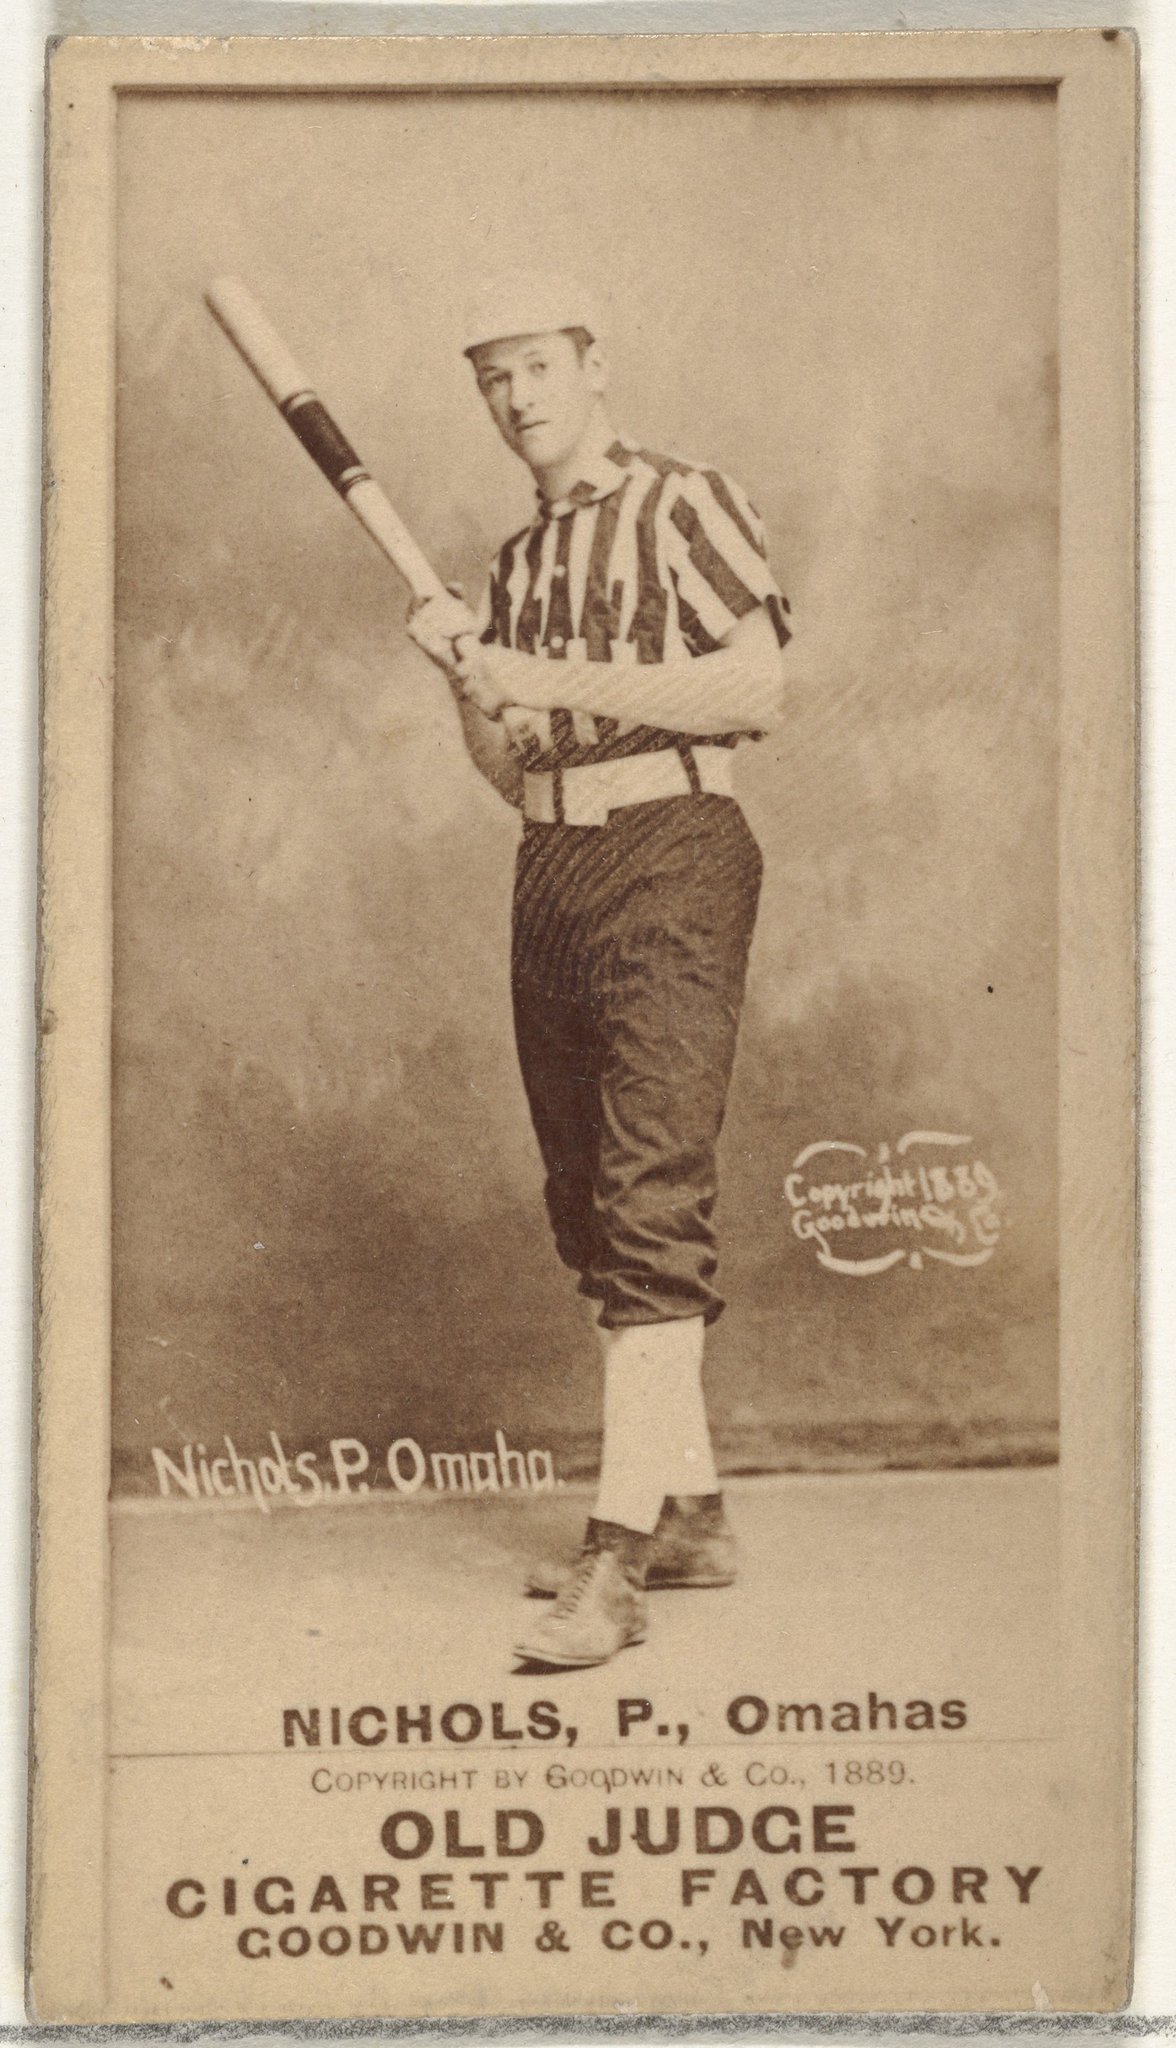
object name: baseball card, photograph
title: Charles Augustus "Kid" Nichols, Pitcher, Omaha Omahogs/ Lambs, from the Old Judge series (N172) for Old Judge Cigarettes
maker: goodwin & company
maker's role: publisher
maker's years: 1850-1950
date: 1889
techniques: albumen silver print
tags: men,portraits,baseball,athletes